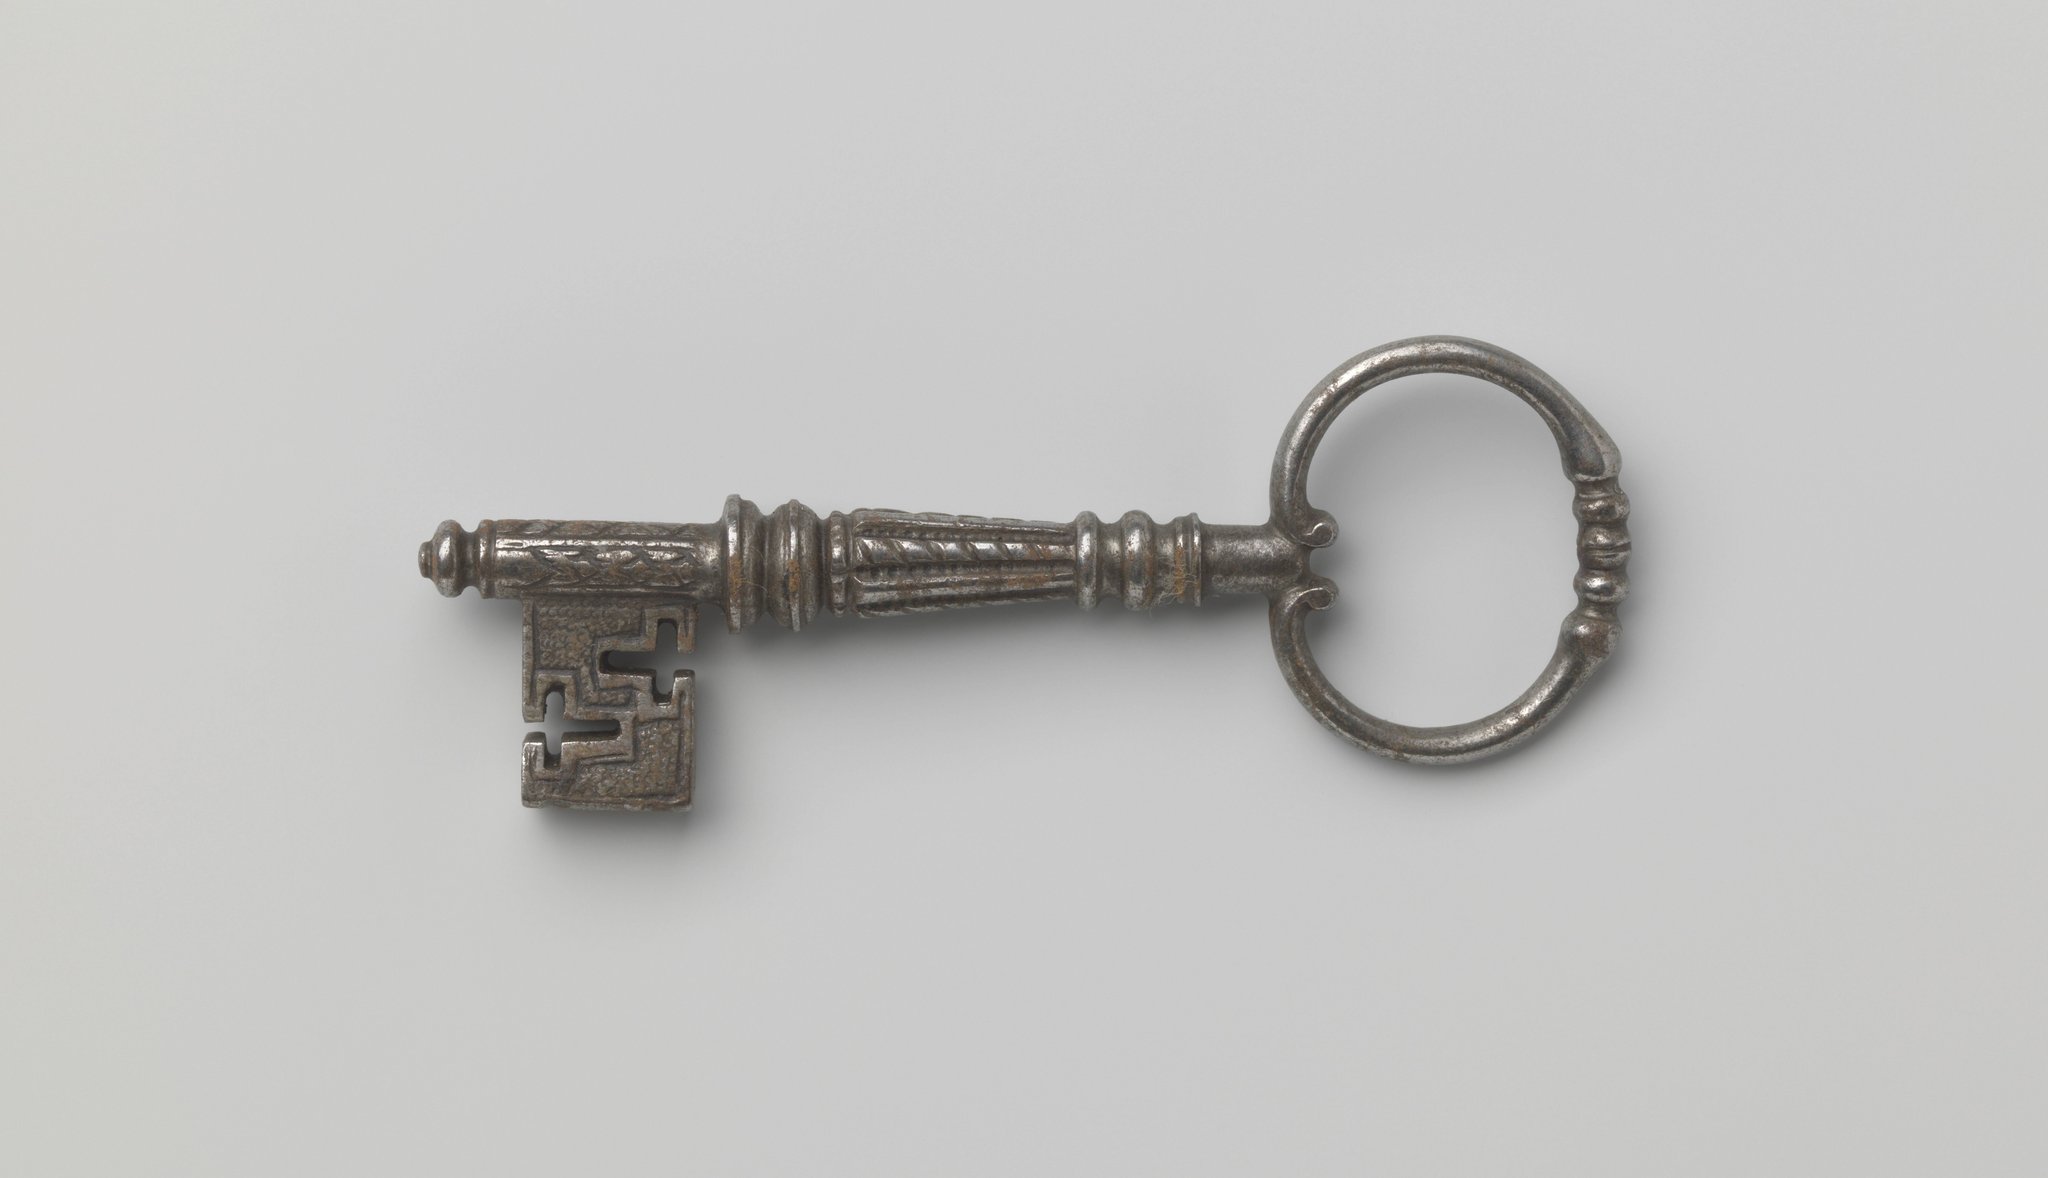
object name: key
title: Sleutel van ijzer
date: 1600-1699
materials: iron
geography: england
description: Gesmeed ijzeren sleutel, versierd met snijwerk en gegraveerd. Ring: liggend ovaal van boven met ringen versierd, van onder in twee voluten samenkomend. Stootring: vlak boven de baard. Pijp: gesloten, balustervormig met ringen en cannelures versierd. Baard: met twee kruisen., grond ruw gemaakt, de baard loopt naar buiten breder uit.